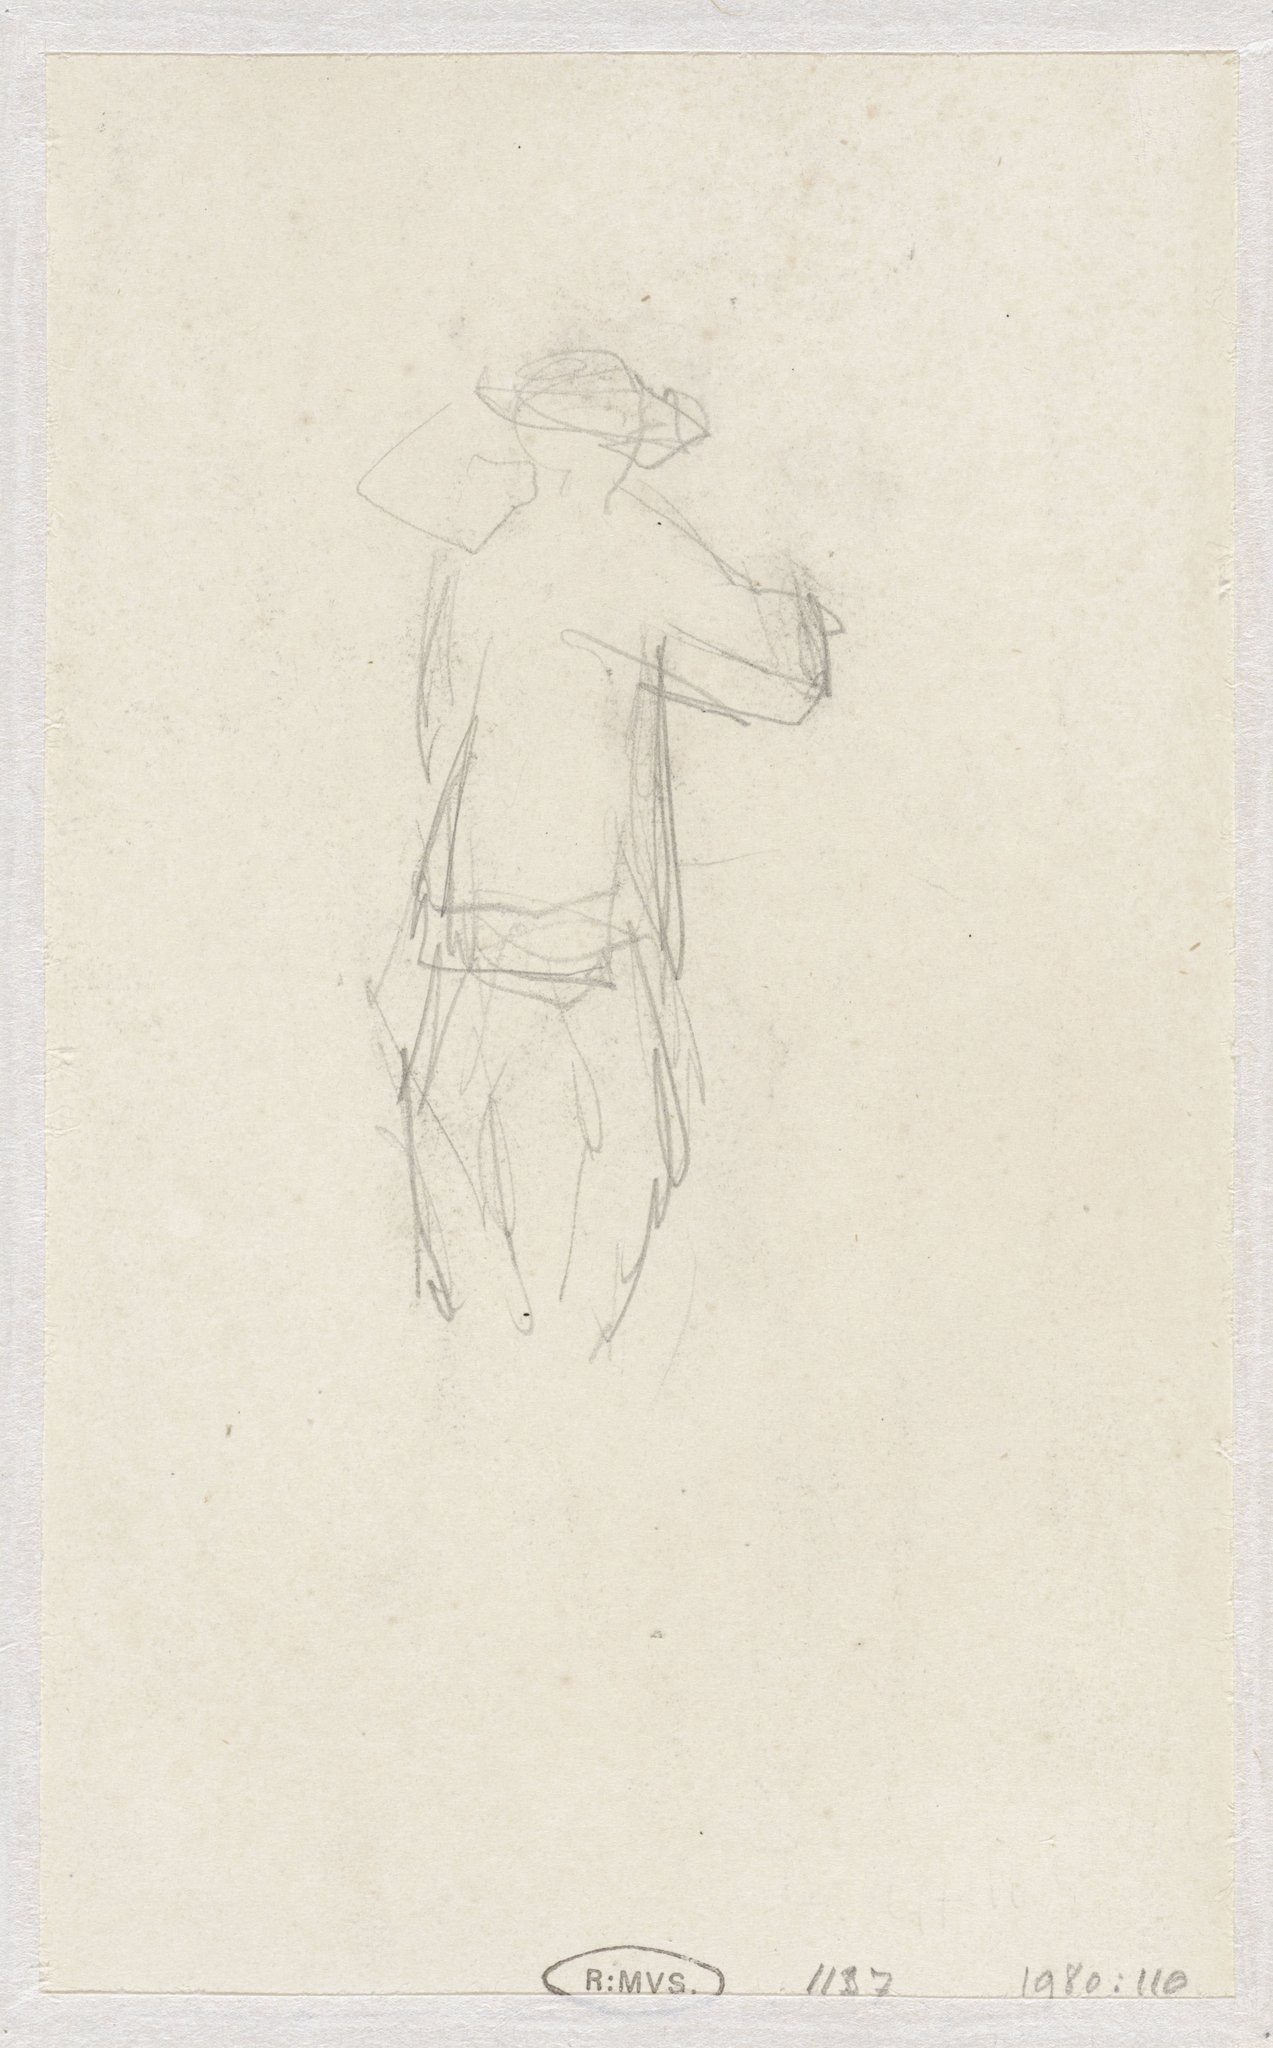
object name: drawing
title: Schets van een staande figuur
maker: jozef israëls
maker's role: draughtsman, painter, print maker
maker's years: 1824-1911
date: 1834-1911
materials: paper, pencil